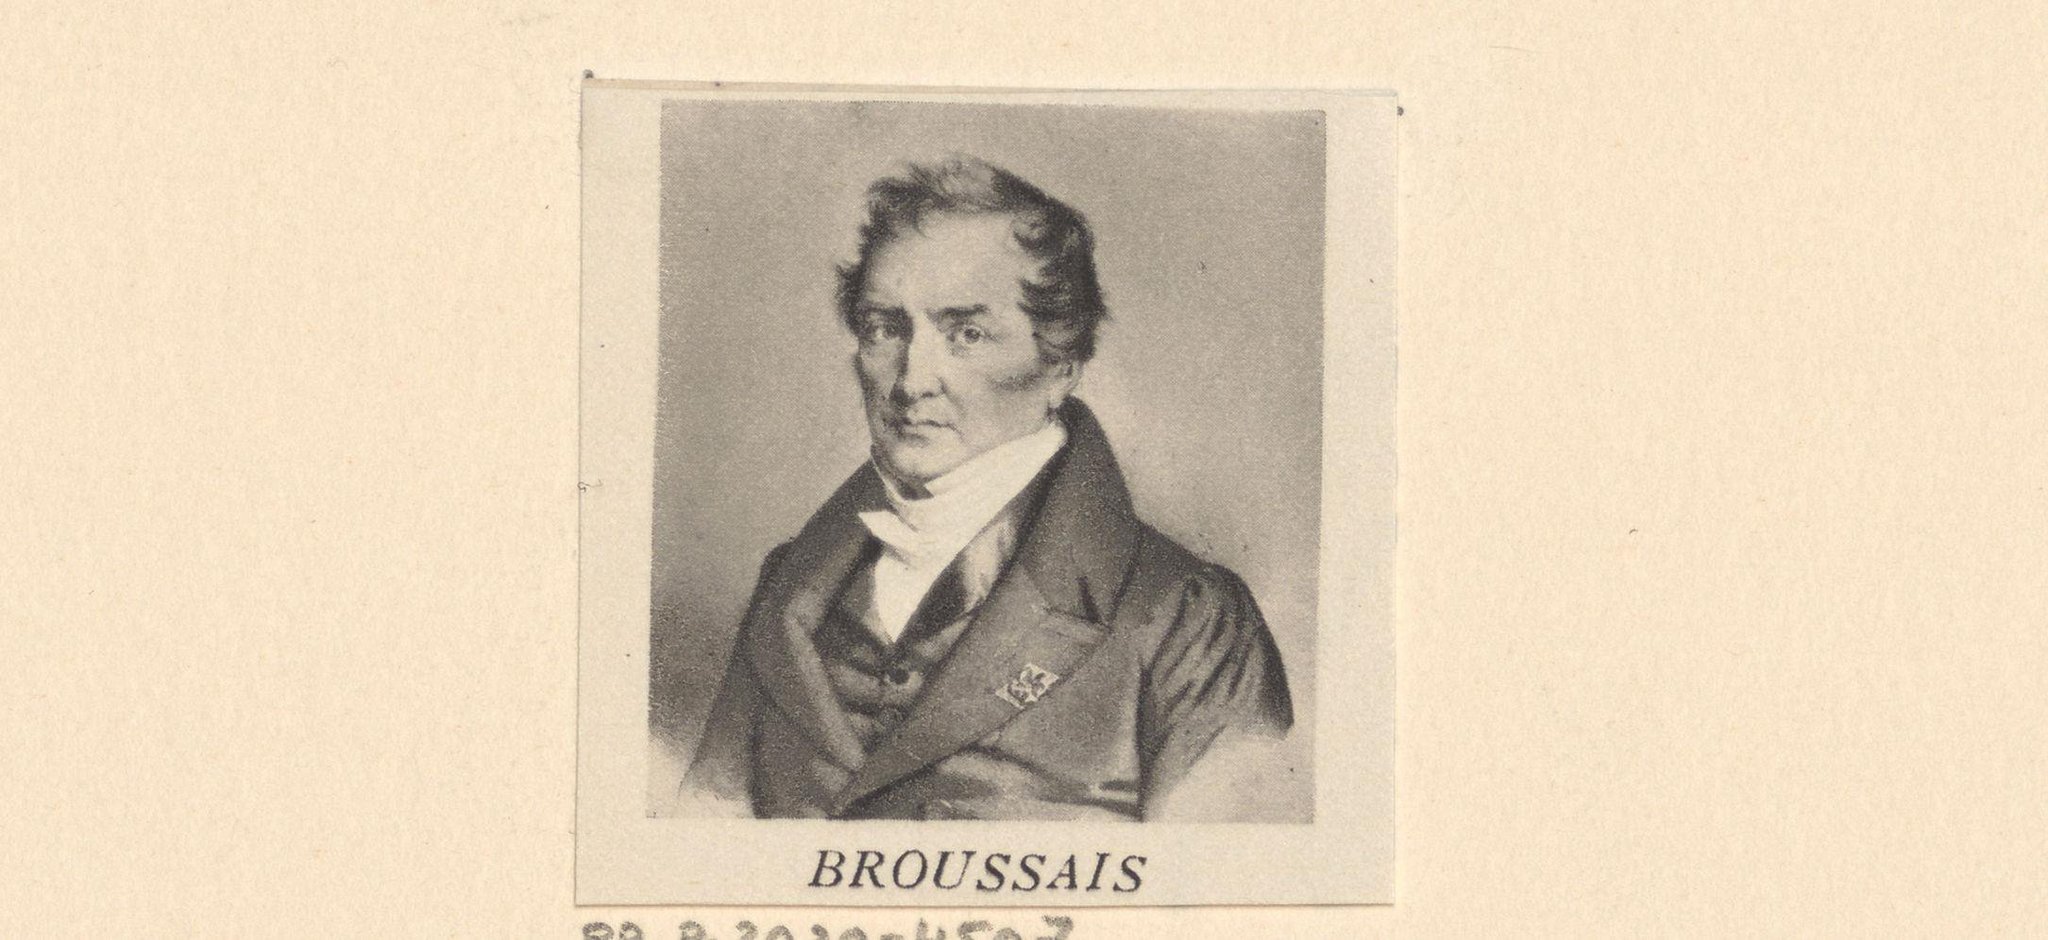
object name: photomechanical print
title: Portret van François Broussais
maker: Anonymous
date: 1895-1940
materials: paper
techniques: rotogravure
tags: historical persons, physician, doctor